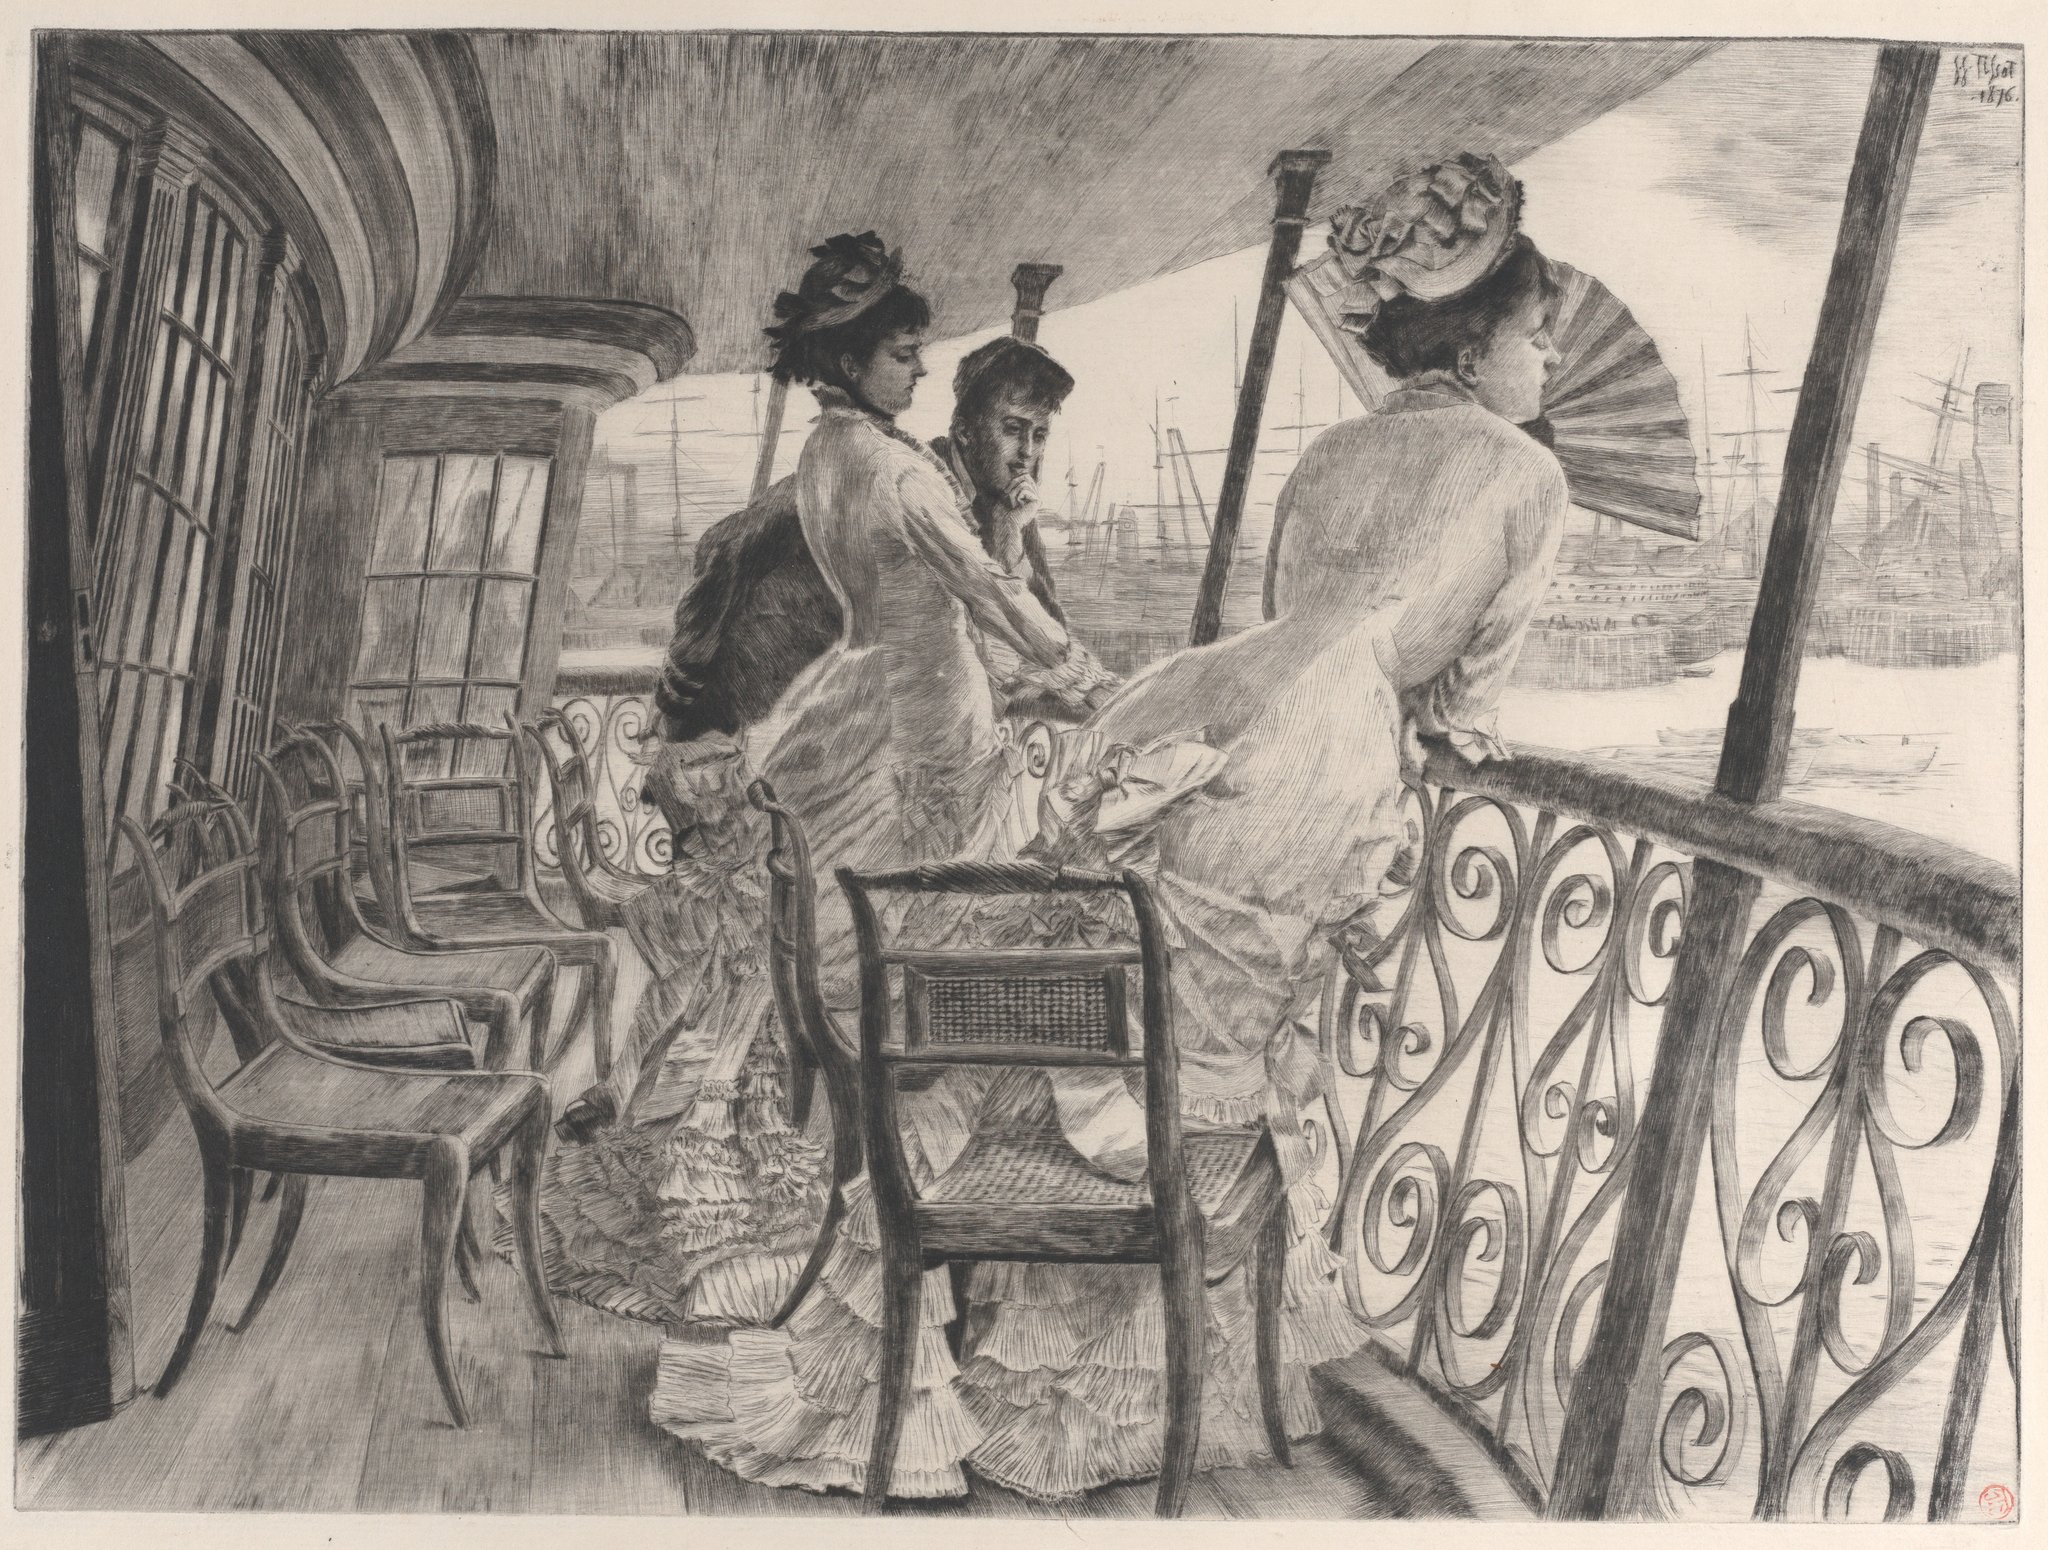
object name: print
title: The Gallery of H.M.S. Calcutta (Souvenir of a Ball on Shipboard) (La galerie du "Calcutta" (Souvenir d'un bal à bord)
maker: james tissot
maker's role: artist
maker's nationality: french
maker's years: 1836-1902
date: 1876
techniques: drypoint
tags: men,women,ships